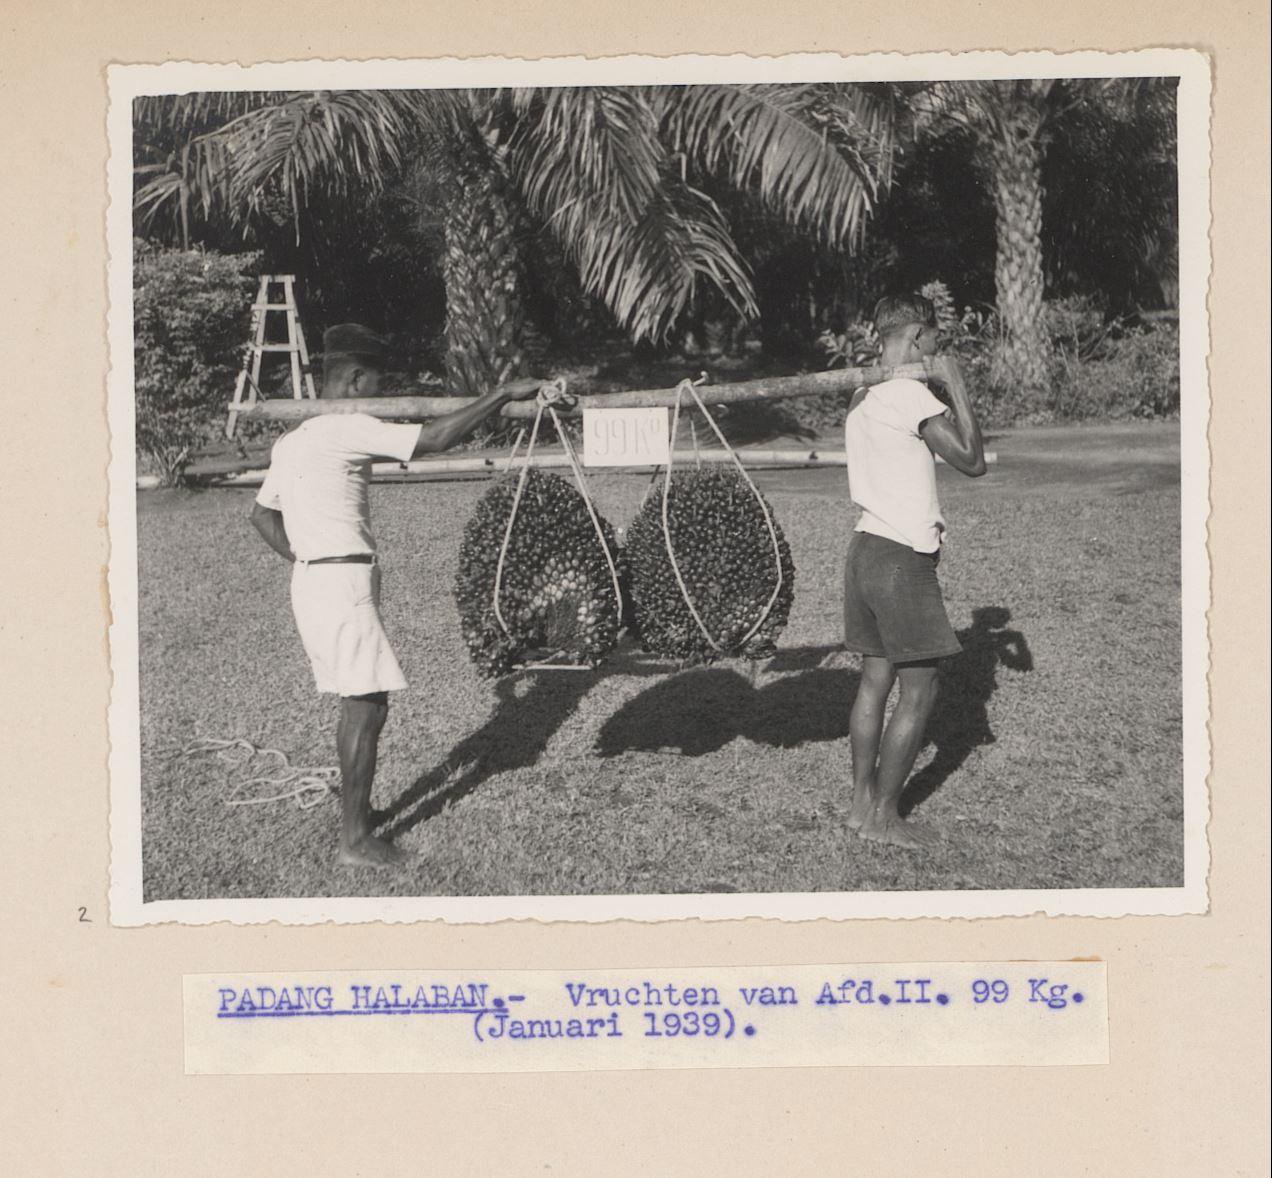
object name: photograph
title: Padang Halaban - Vruchten van Afd. II. 99 Kg. (Januari 1939)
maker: Anonymous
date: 1901-1939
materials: photographic support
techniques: gelatin silver print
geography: sumatra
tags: asiatic races and peoples (indonesians), plantation, (non-fruit) products of plants or trees: palm oil, sumatra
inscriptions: inscription: ‘Padang Halaban - Vruchten van Afd. II. 99 Kg. (Januari 1939)’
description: Twee dragers met trossen vruchten van oliepalmen op de plantage Padang Halaban, januari 1939. Onderdeel van het fotoalbum over de plantages Pernantian en Brussel van de Sumatra Caoutchouc Maatschappij op de Oostkust van Sumatra in de jaren 1935-1939.